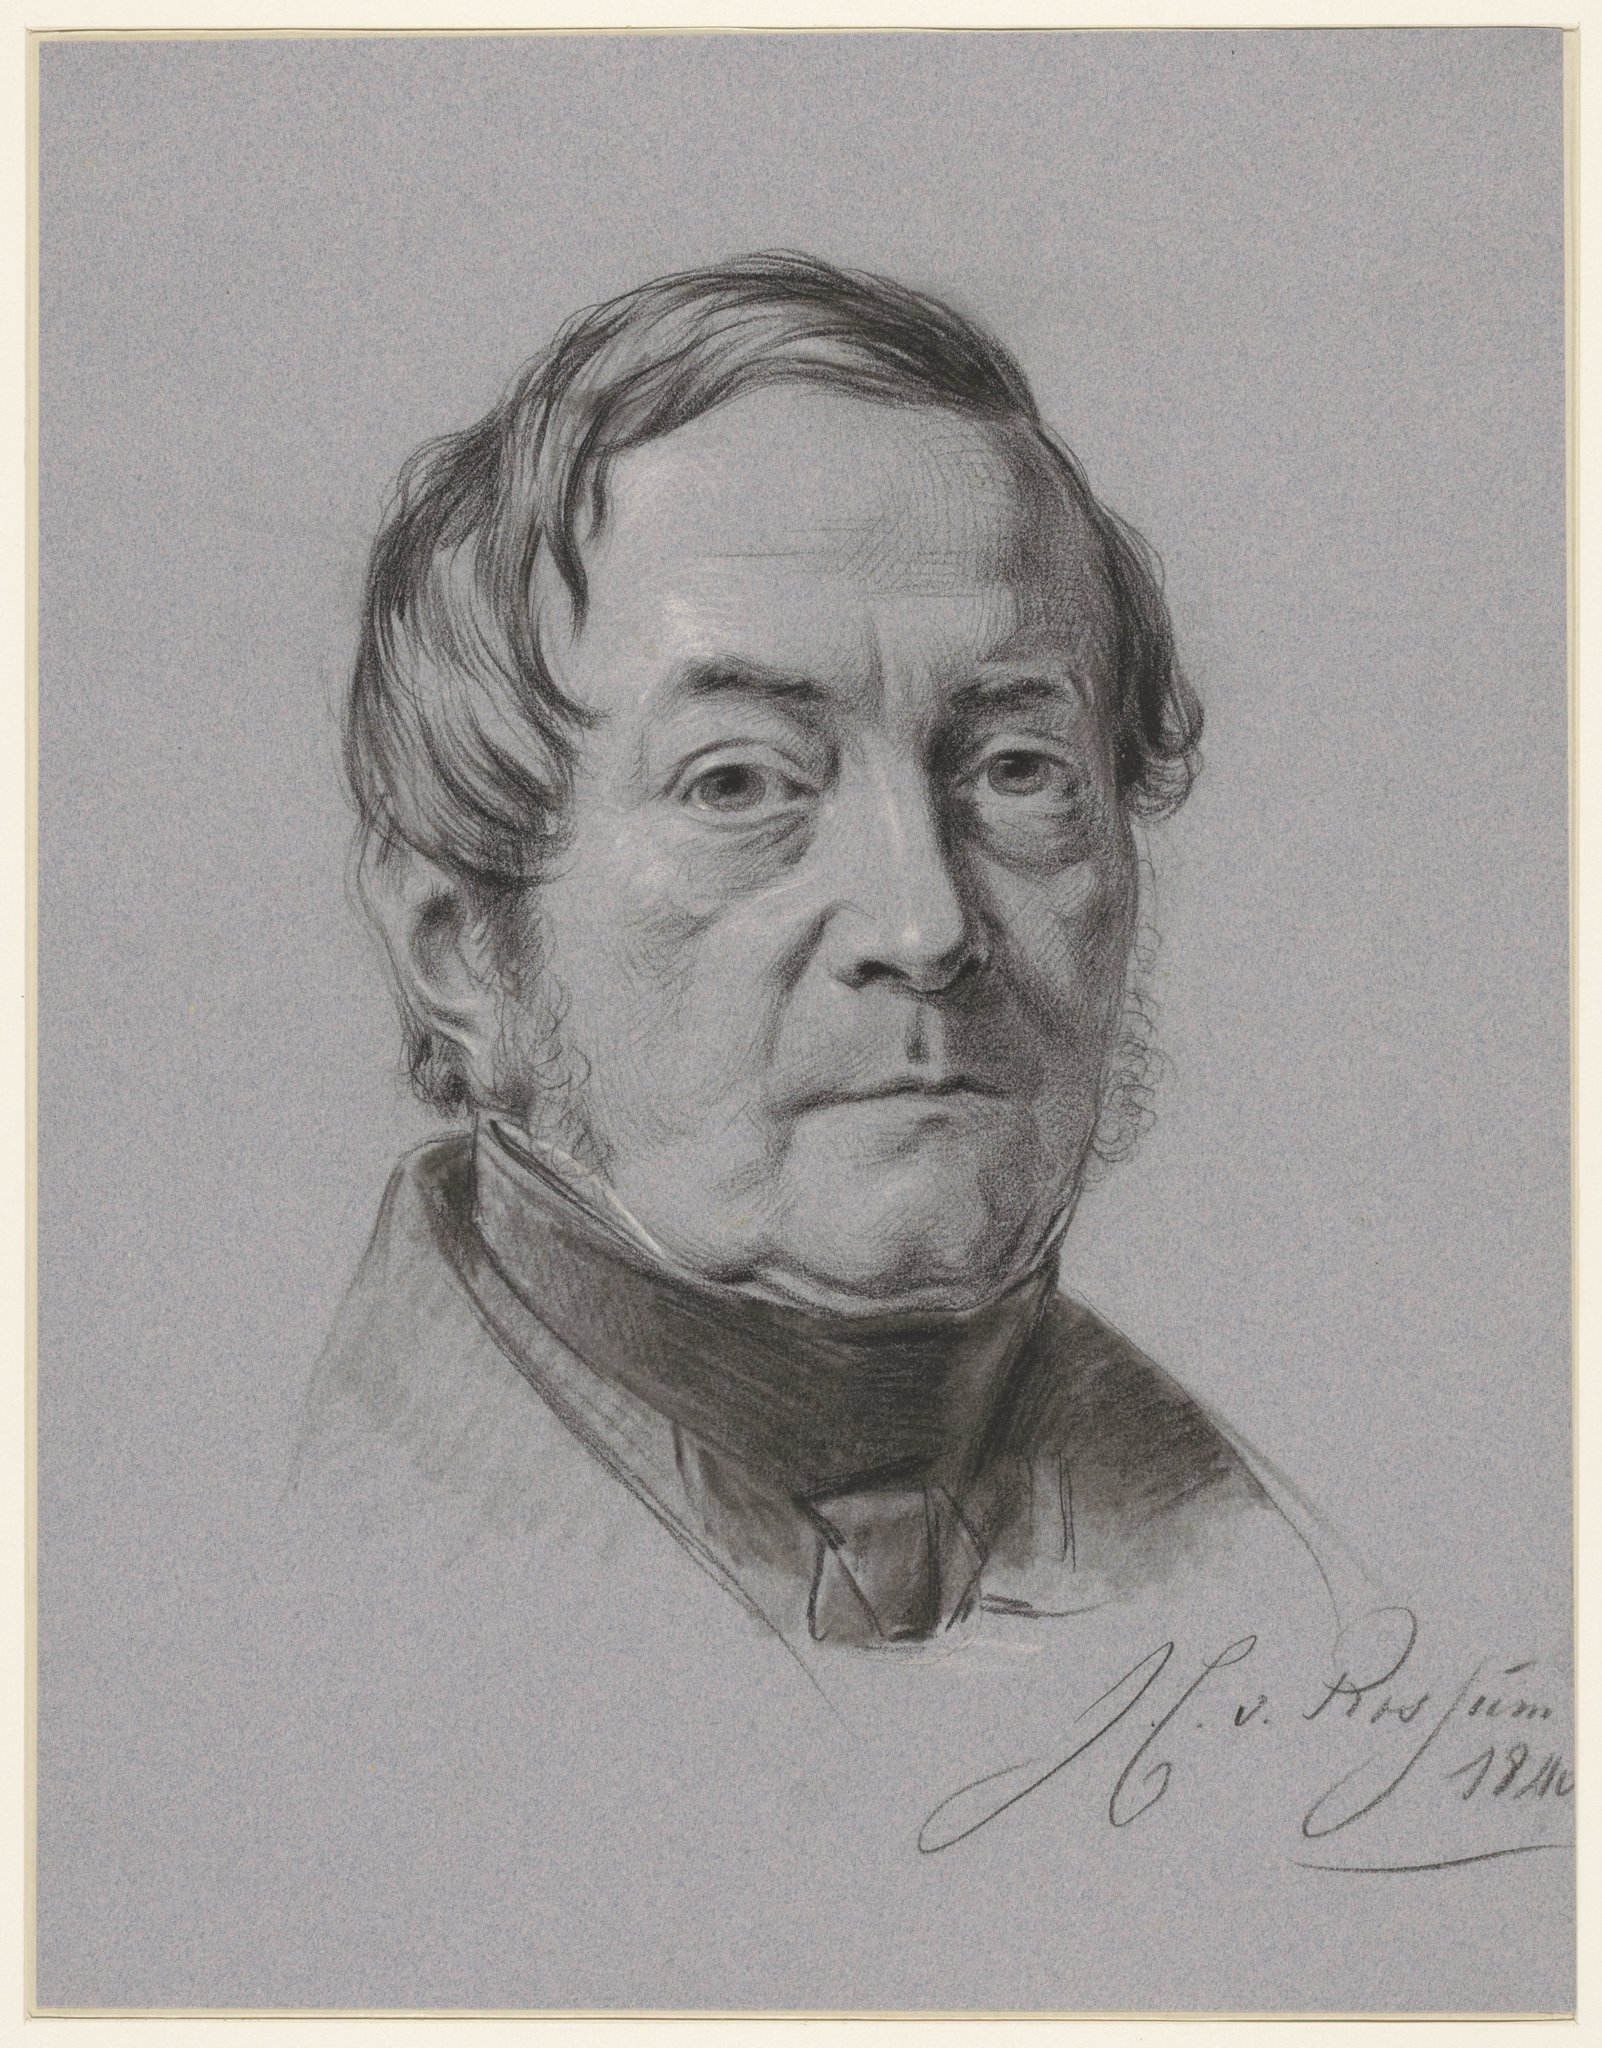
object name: drawing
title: Portret van de graveur Willem Grebner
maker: jan cornelis van rossum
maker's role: draughtsman, painter, print maker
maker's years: 1820-1905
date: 1840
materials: chalk, charcoal, paper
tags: willem grebner, historical persons, portrait, self-portrait of artist, portrait, self-portrait of graphic artist